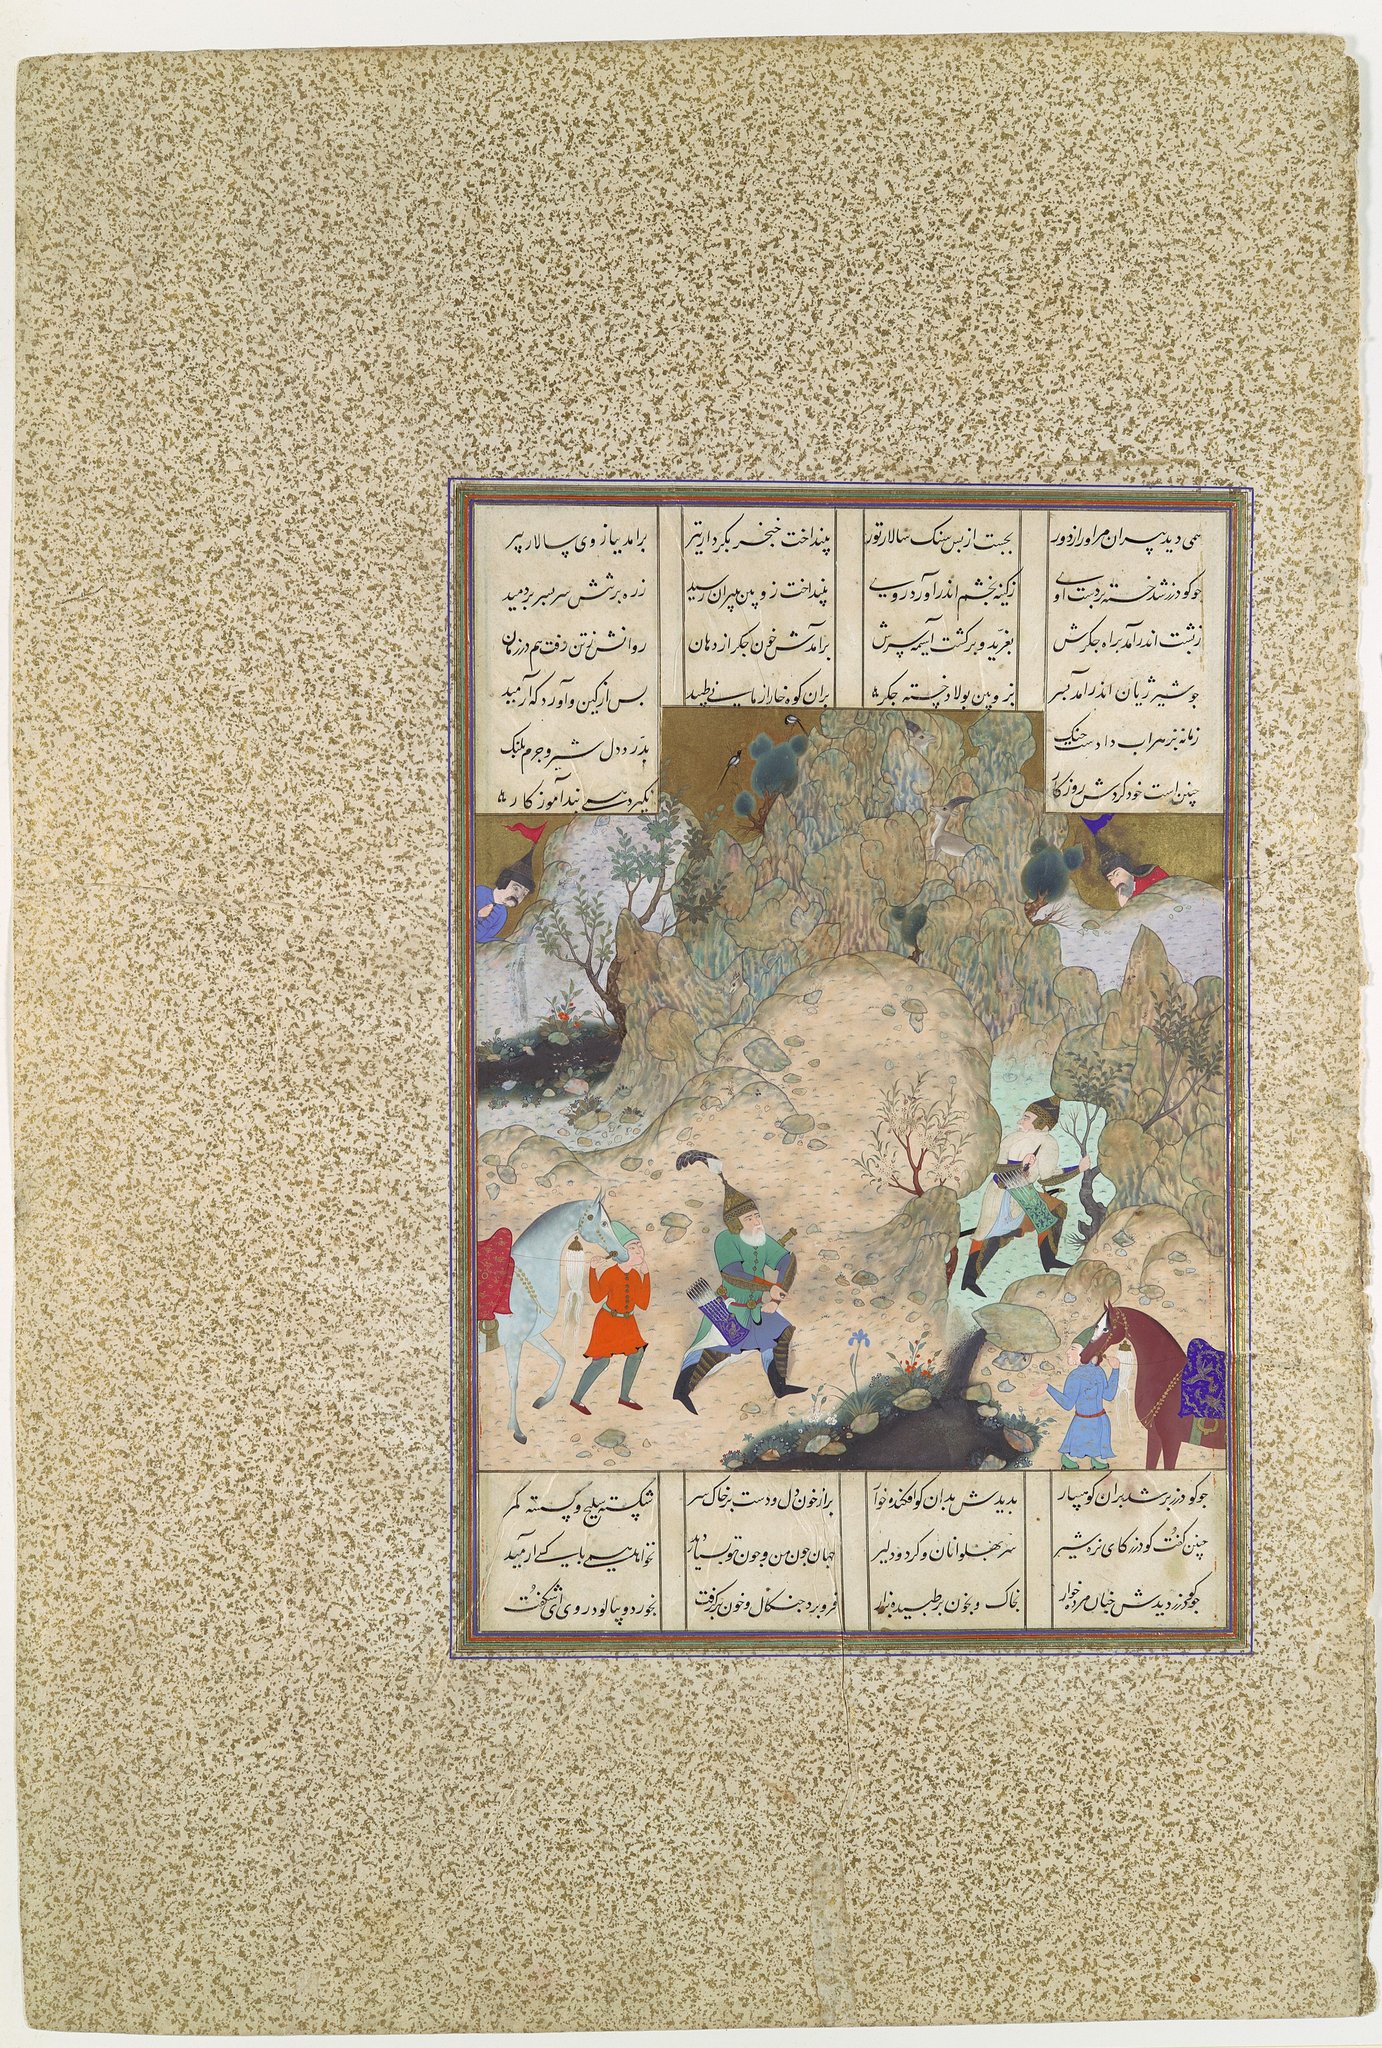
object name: folio from an illustrated manuscript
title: "The Final Joust of the Rooks: Gudarz Versus Piran", Folio 346r from the Shahnama (Book of Kings) of Shah Tahmasp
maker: abu'l qasim firdausi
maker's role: author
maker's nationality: iranian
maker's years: 935-1020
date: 1525-1530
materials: gold, ink, paper, silver, watercolor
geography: iran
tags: men,horses